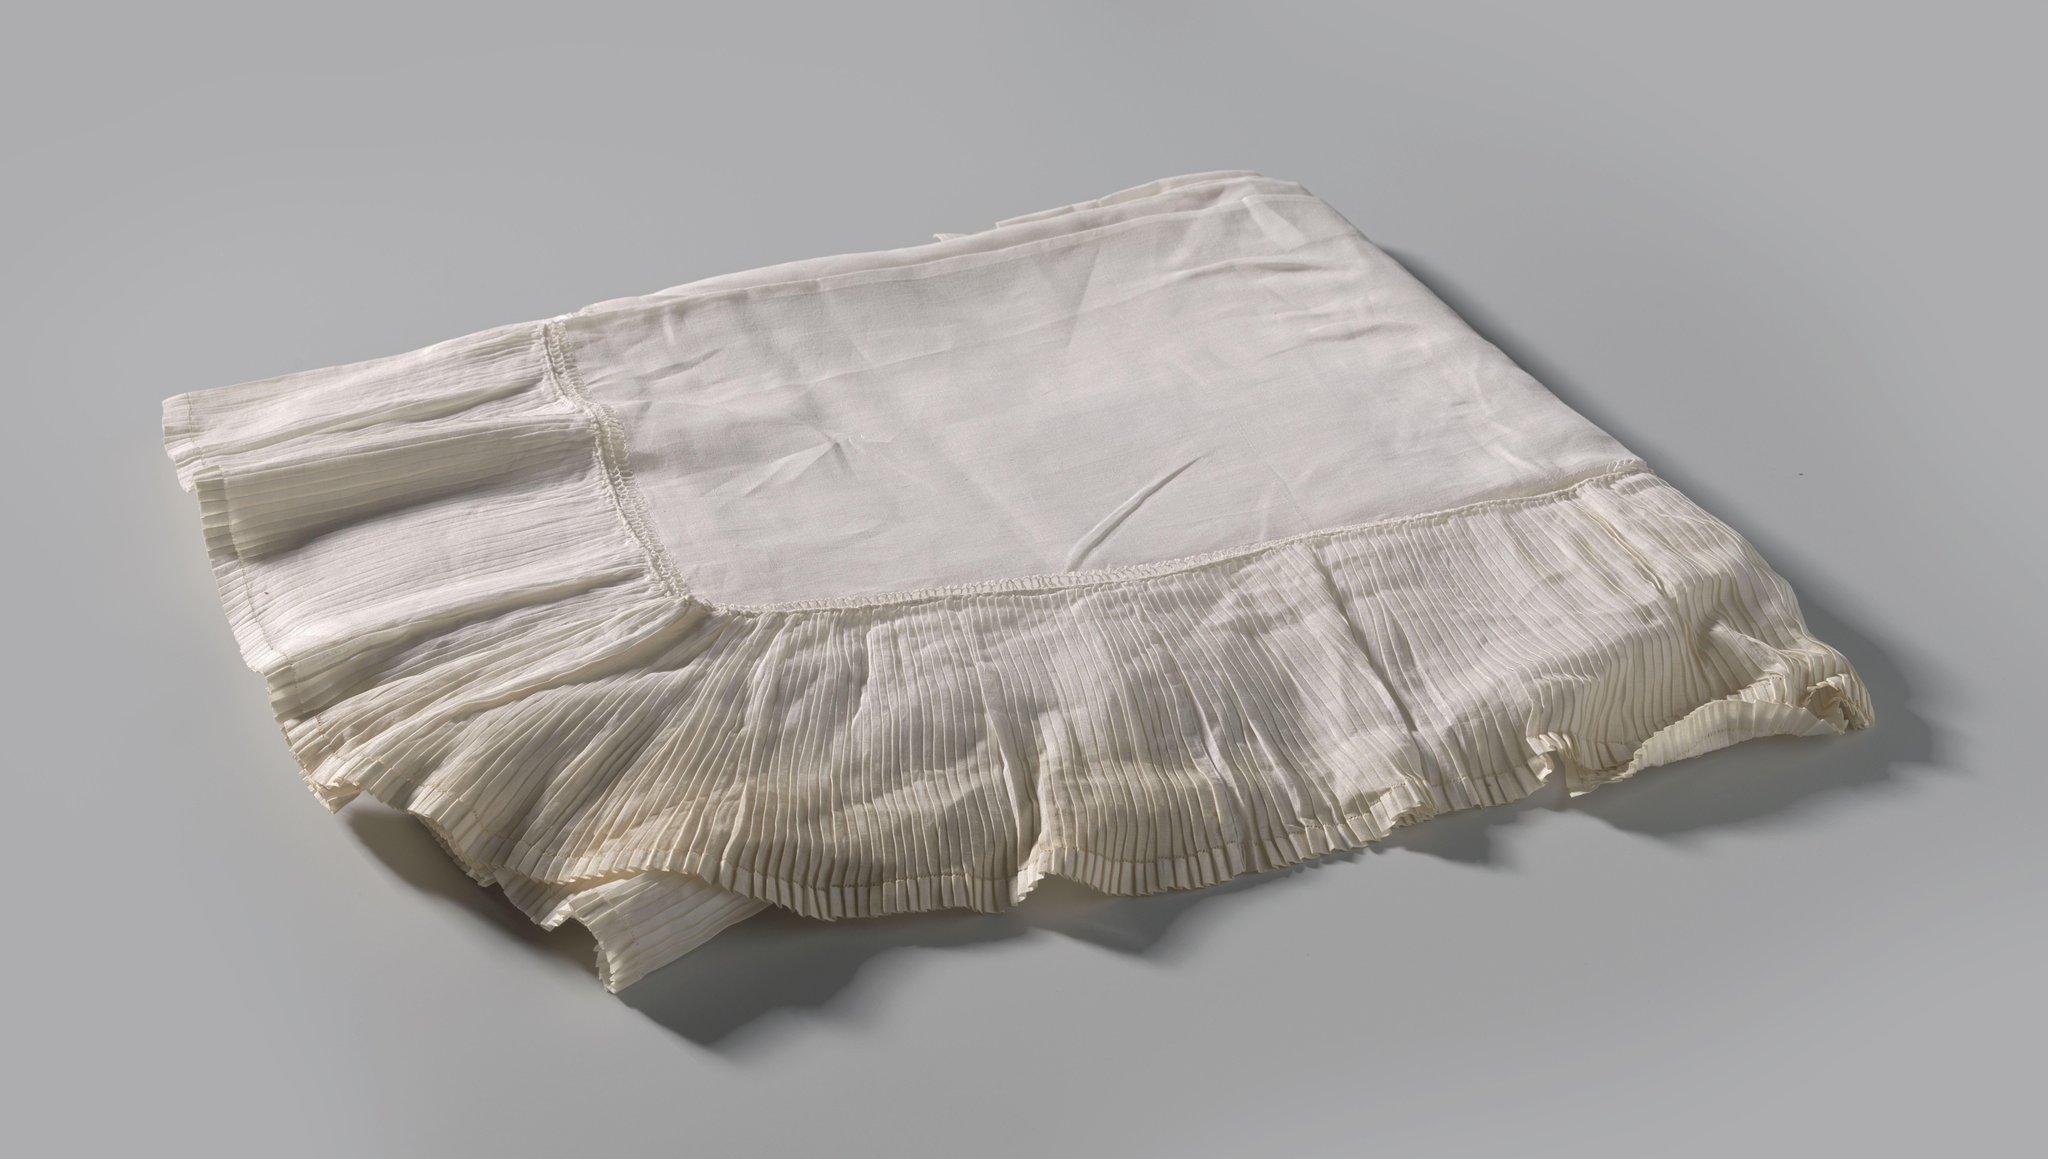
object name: beddenlaken, laken object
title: Laken van linnen met aan de bovenzijde aangezette geplooide strook, geappliceerde bladeren en de initialen BU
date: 1935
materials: linen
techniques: embroidered, weave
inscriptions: laundry mark: ‘5831 Plissier - TRAVAIL MAIN // RECOMMANDÉ’, initials: ‘BU’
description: Laken van linnen in platbinding, met aan de bovenzijde een aangezette geplooide strook. Een deel van de zijden en de onderzijde heeft een open zoom. De bovenzijde is versierd met geappliceerde bladeren en een inzet met de initialen BU (Brusse-Urtebise). Het laken is voozien van een wasmerk.